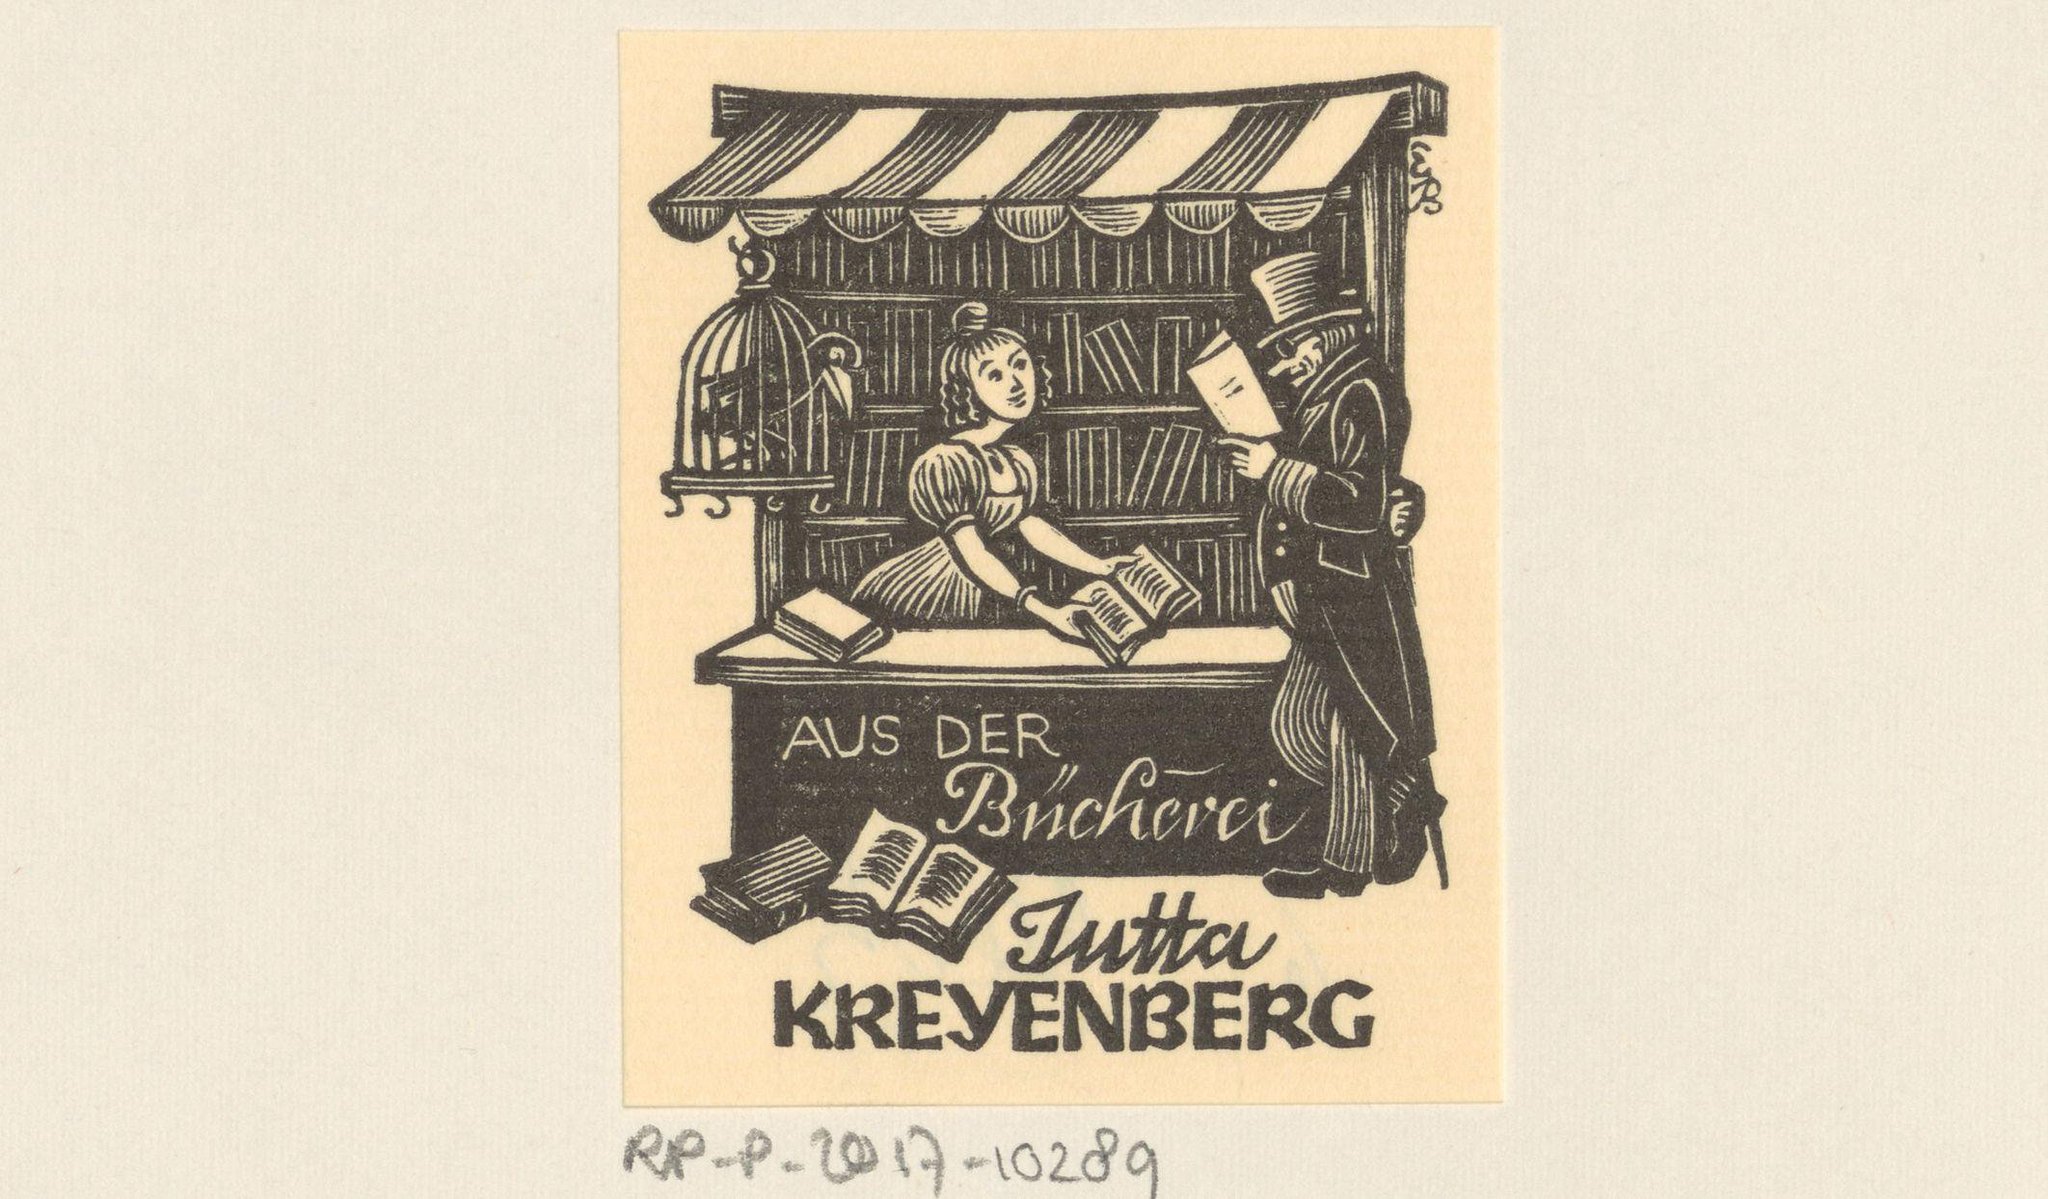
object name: bookplate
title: Aus der Bücherei Jutta Keyenberg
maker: ellen beck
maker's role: print maker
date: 1900-1999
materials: paper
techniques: woodcut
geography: germany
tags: reading, song-birds: crow, old man, book, standing figure - aa - female human figure